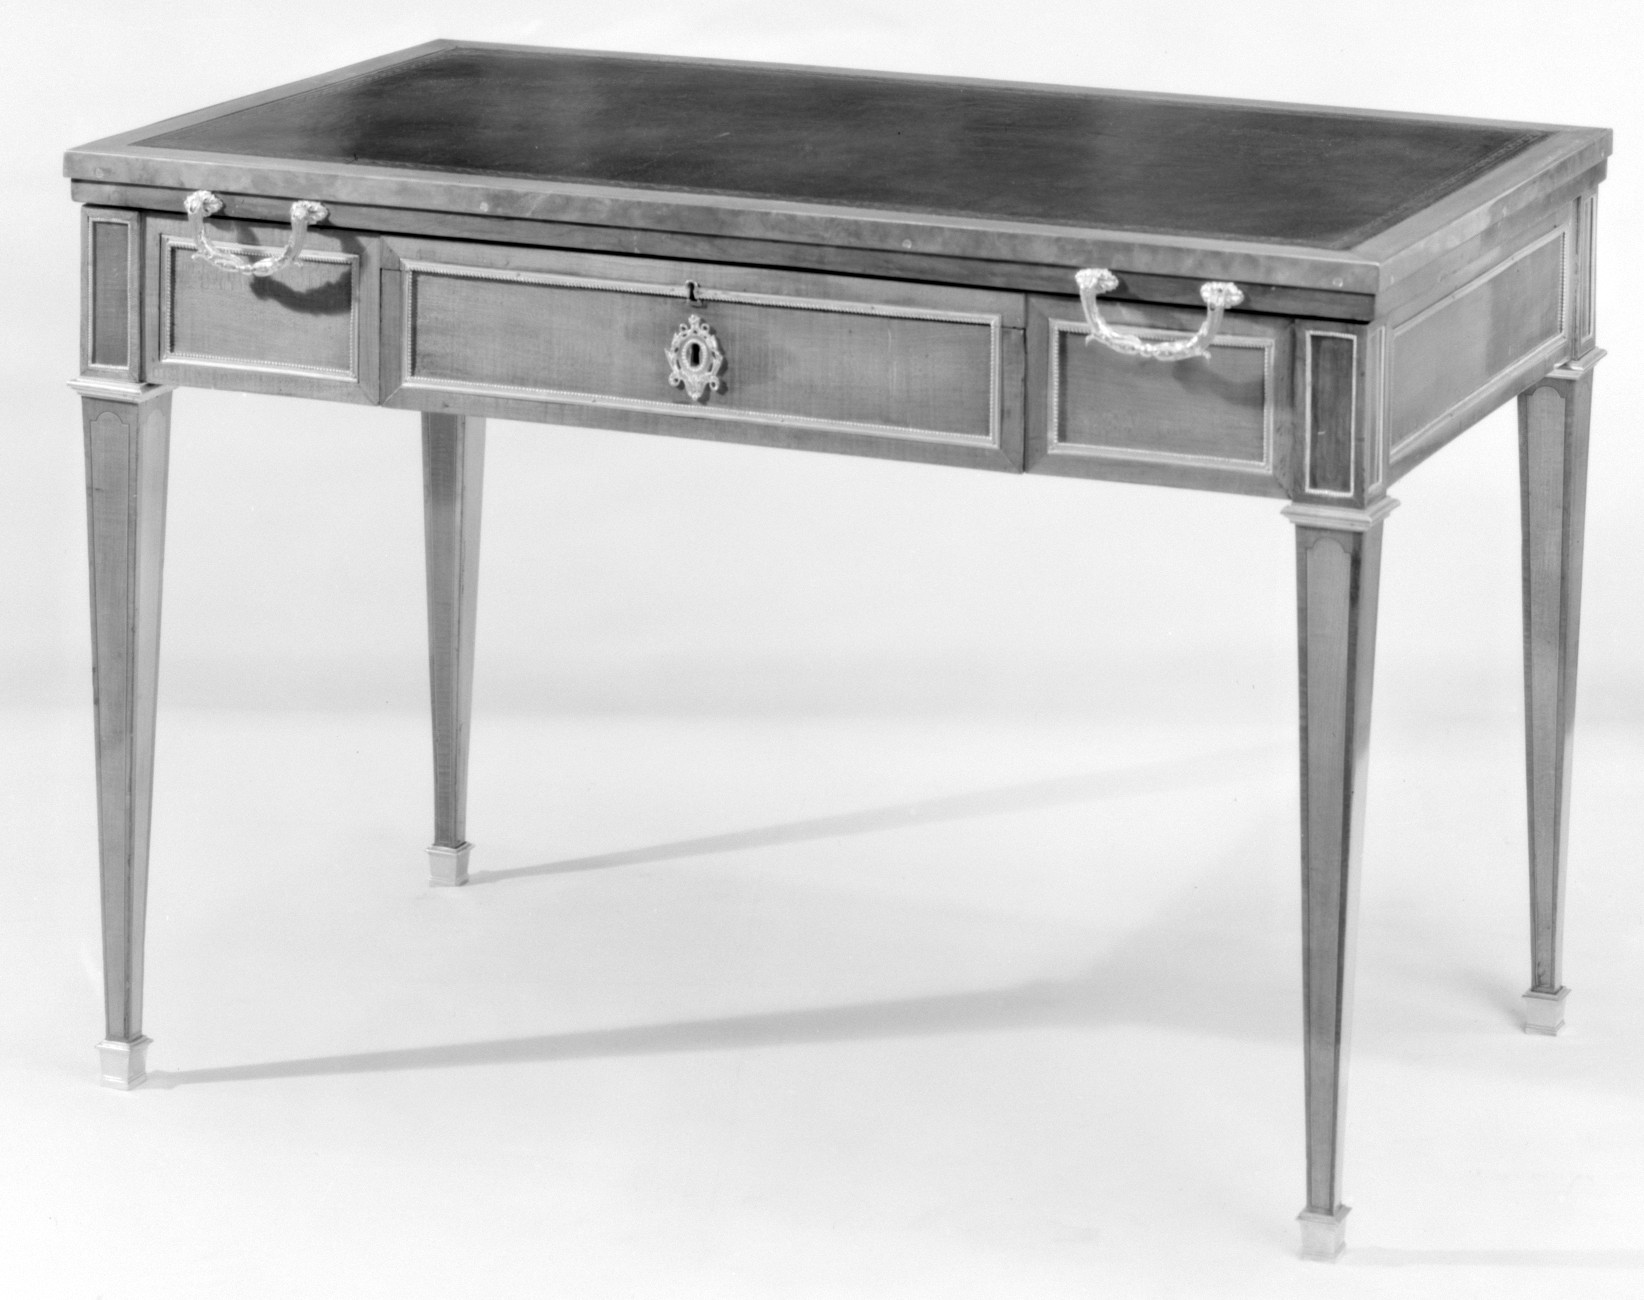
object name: writing and dressing table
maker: martin carlin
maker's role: maker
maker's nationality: french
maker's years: 1725-1785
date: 1785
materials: wood, brass, gilt bronze, leather, marble, steel